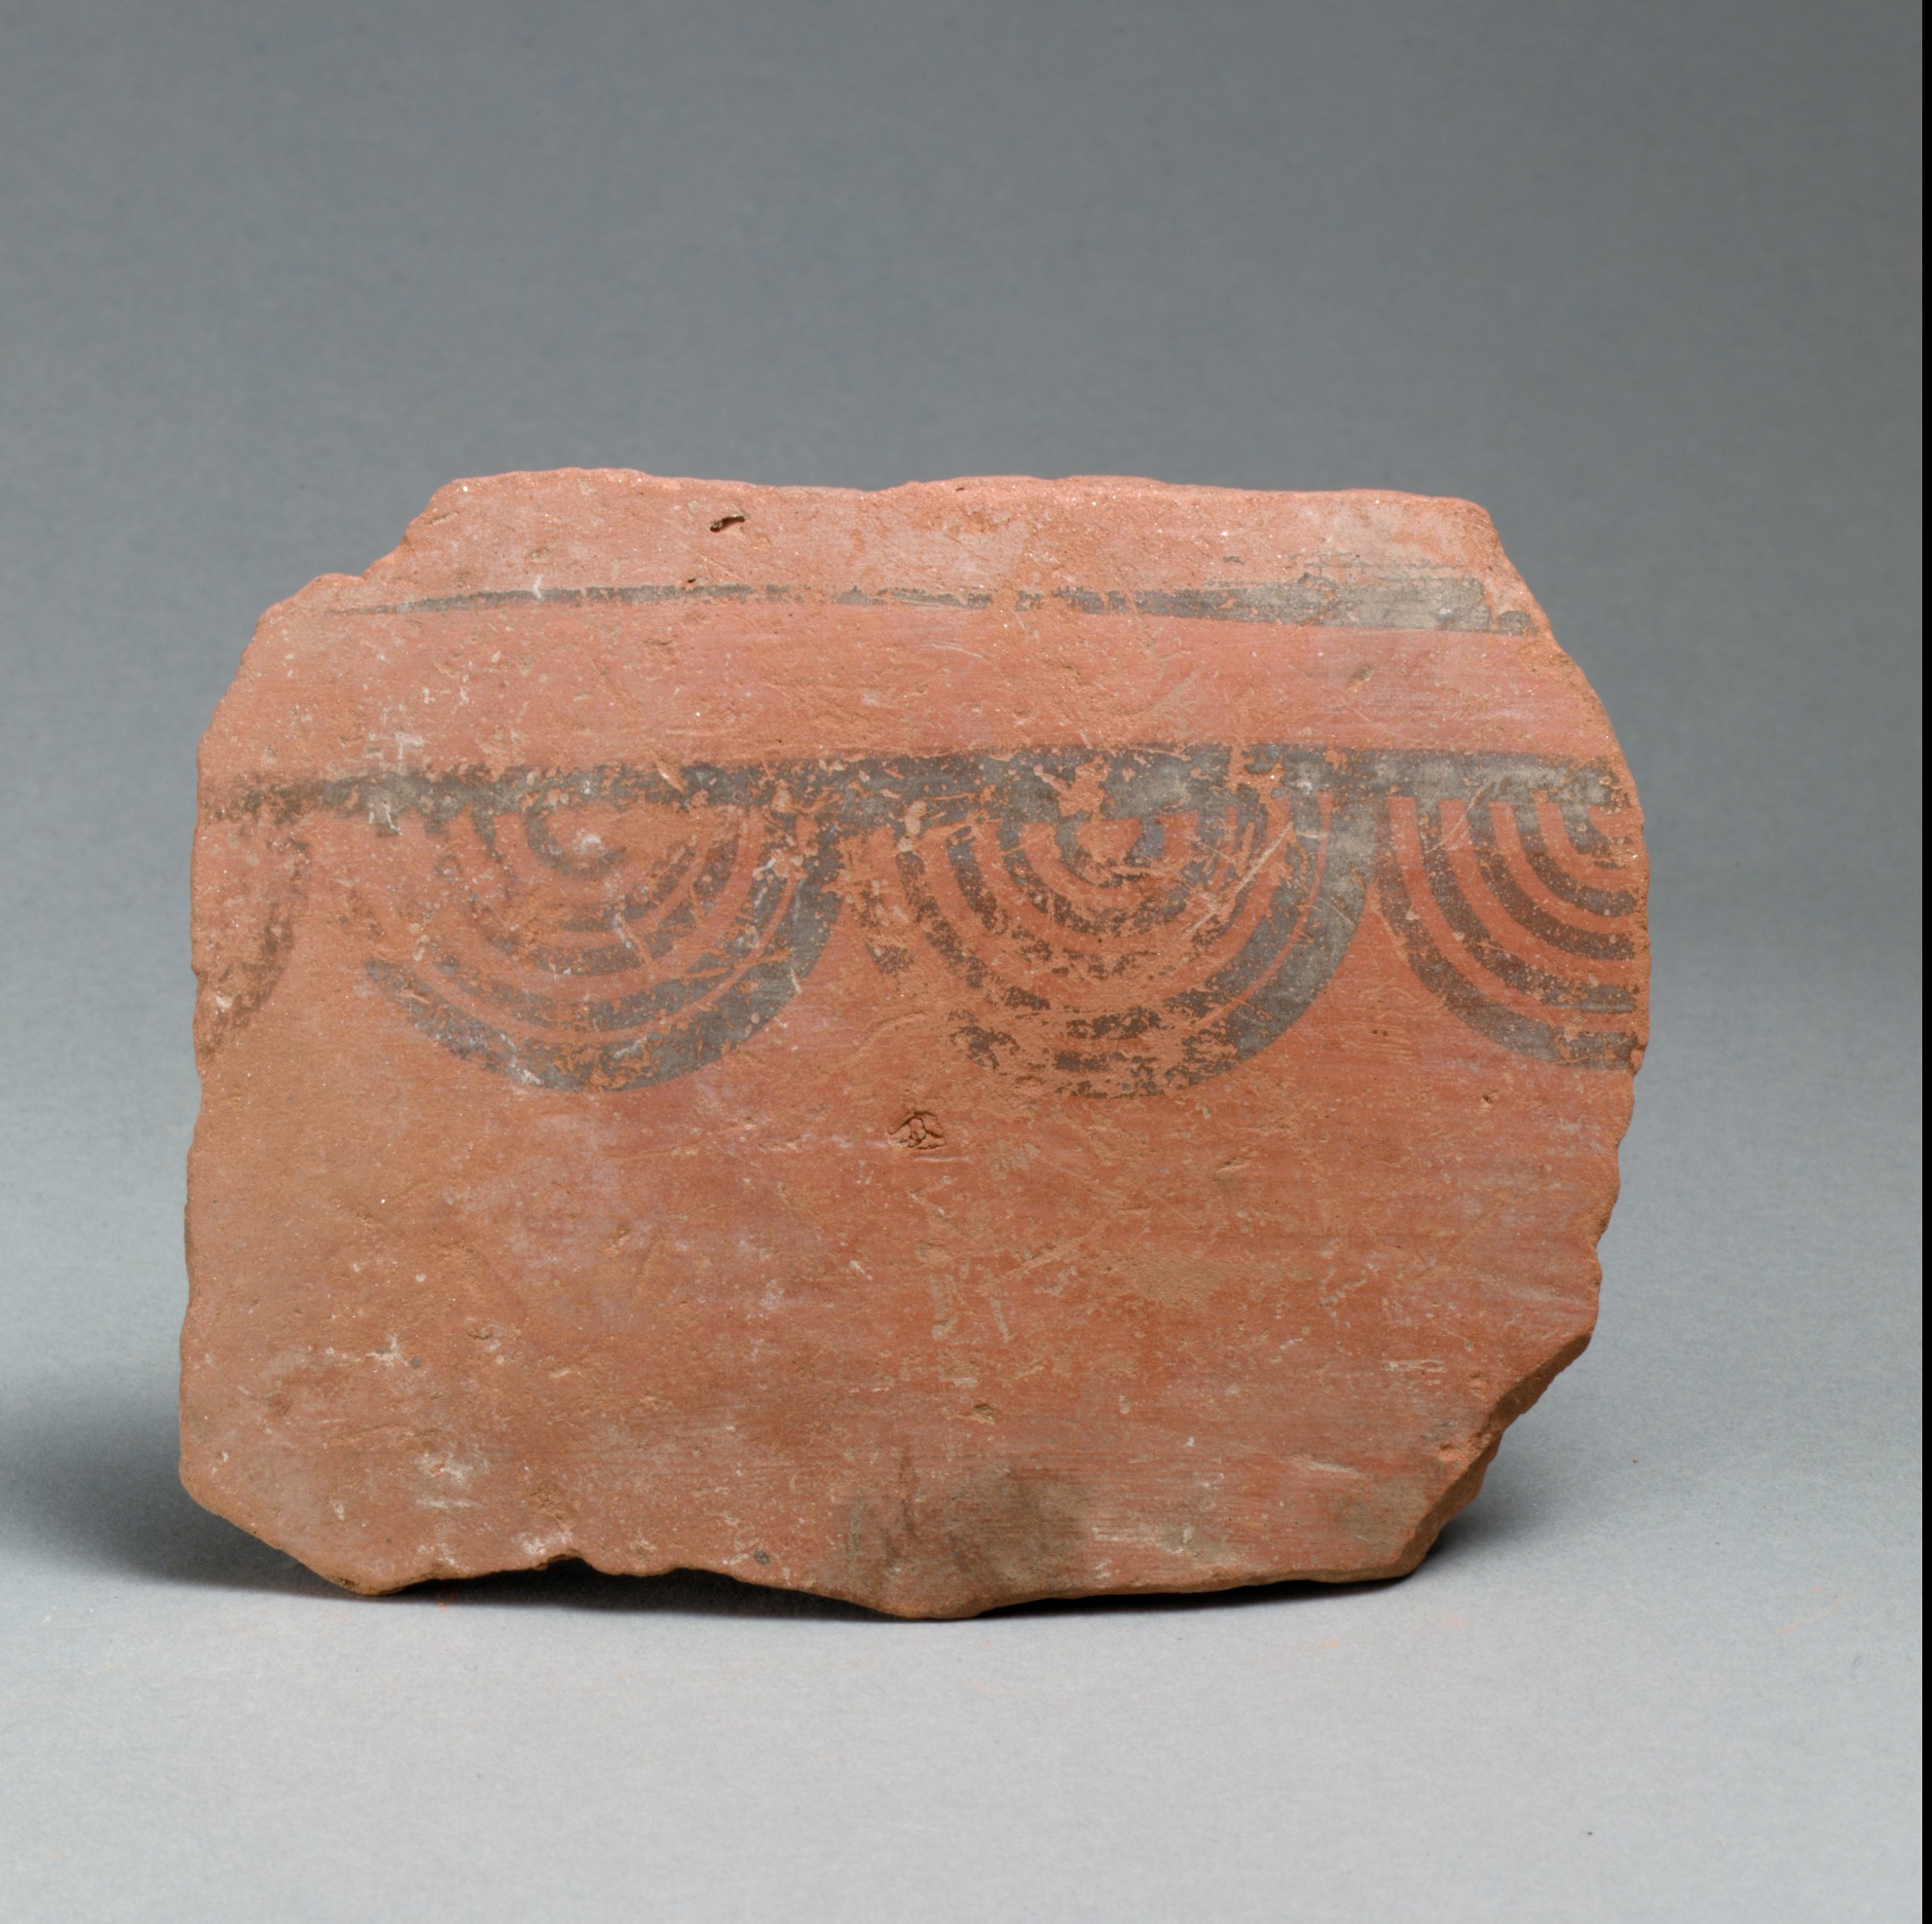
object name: vase fragment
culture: greek or lydian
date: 1050-700 BCE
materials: terracotta